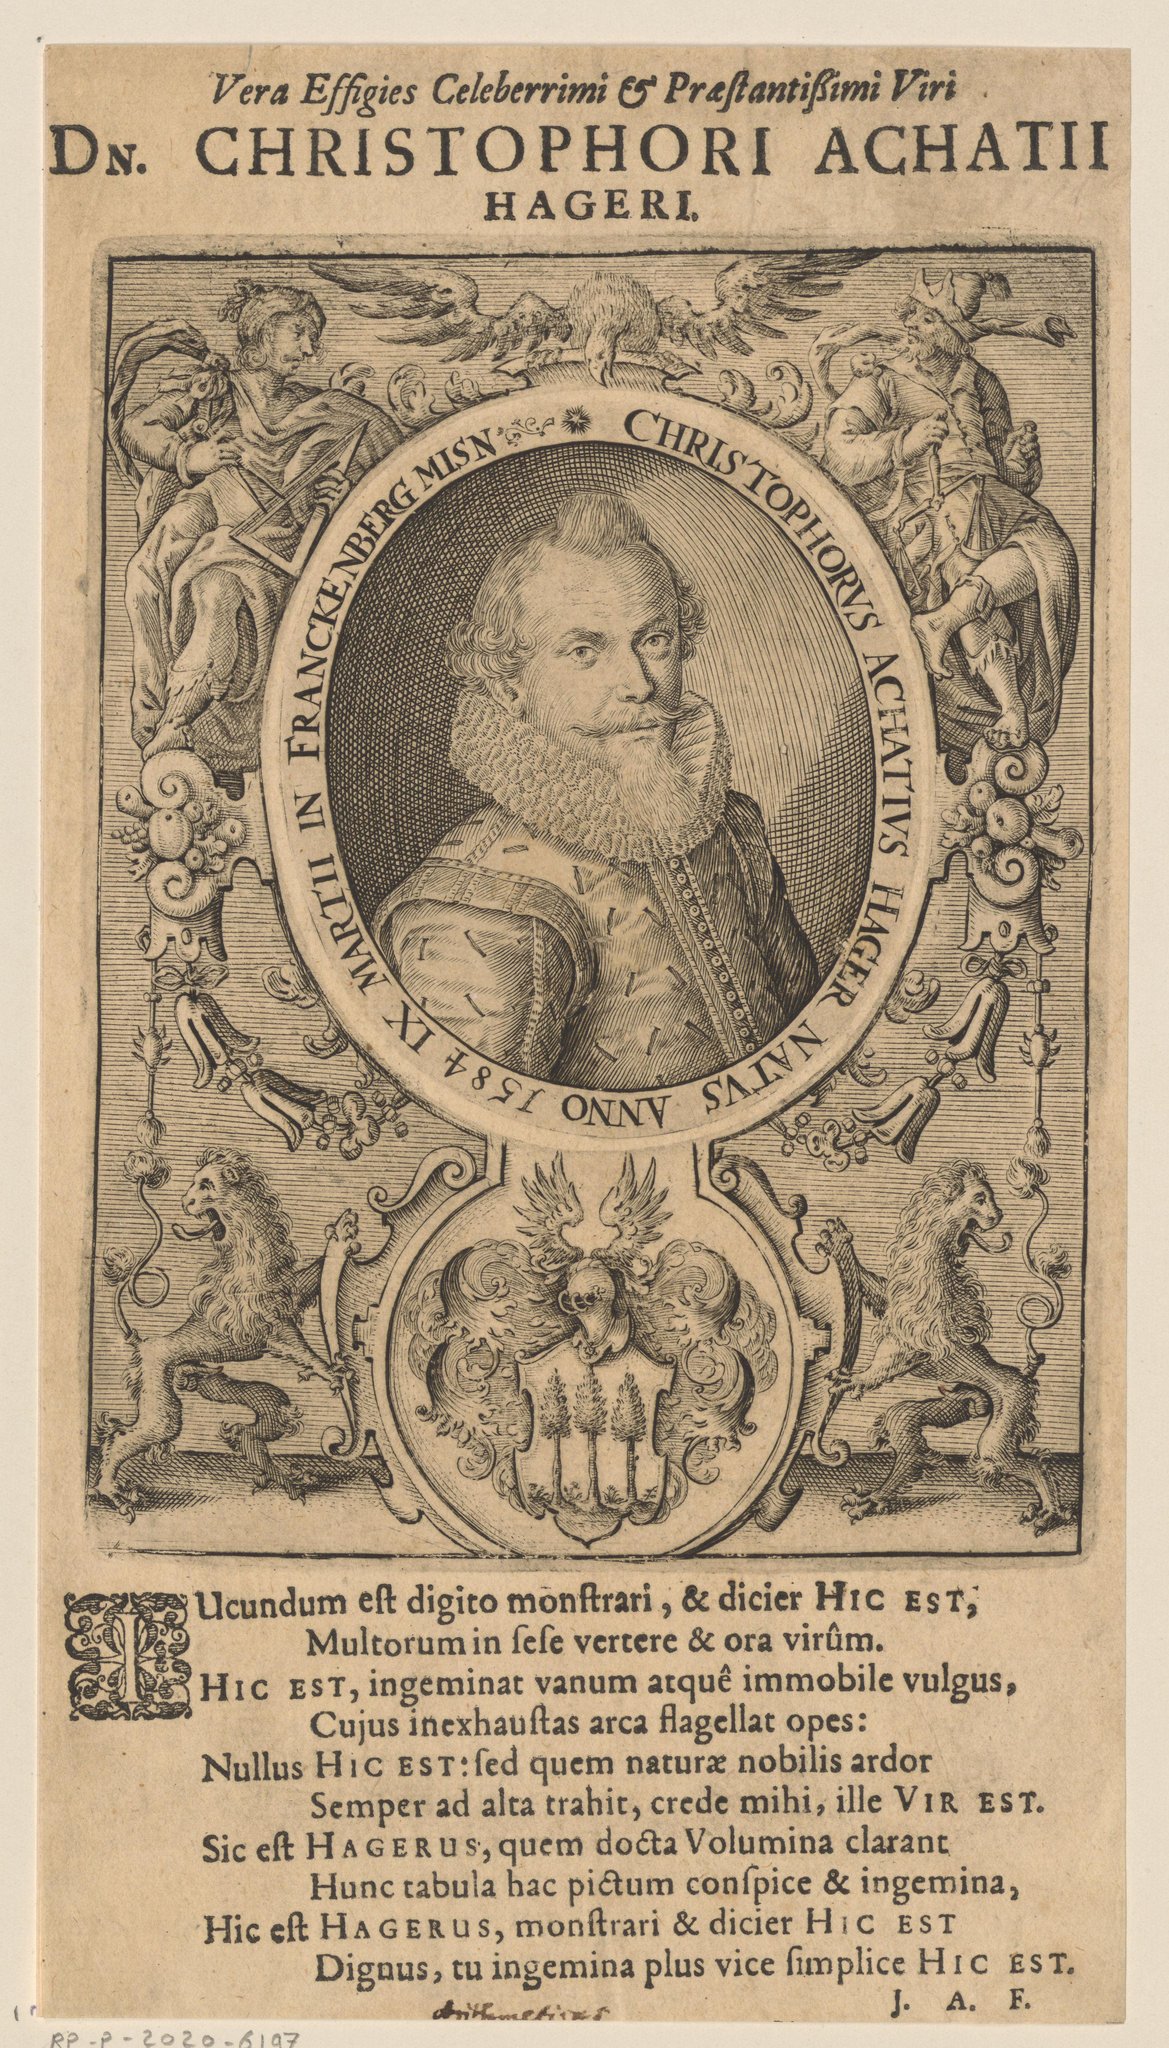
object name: print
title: Portret van Christoph Achaz Hager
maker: Anonymous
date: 1662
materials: paper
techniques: engraving, letterpress printing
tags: 'mathematica'; 'mathematica' (ripa), arithmetic, historical persons, armorial bearing, heraldry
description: Prent uit: Hager, Christoph Achaz. Buchhalten über proper Commission und Compagnia Handlungen. S.l.s.n., 1662.